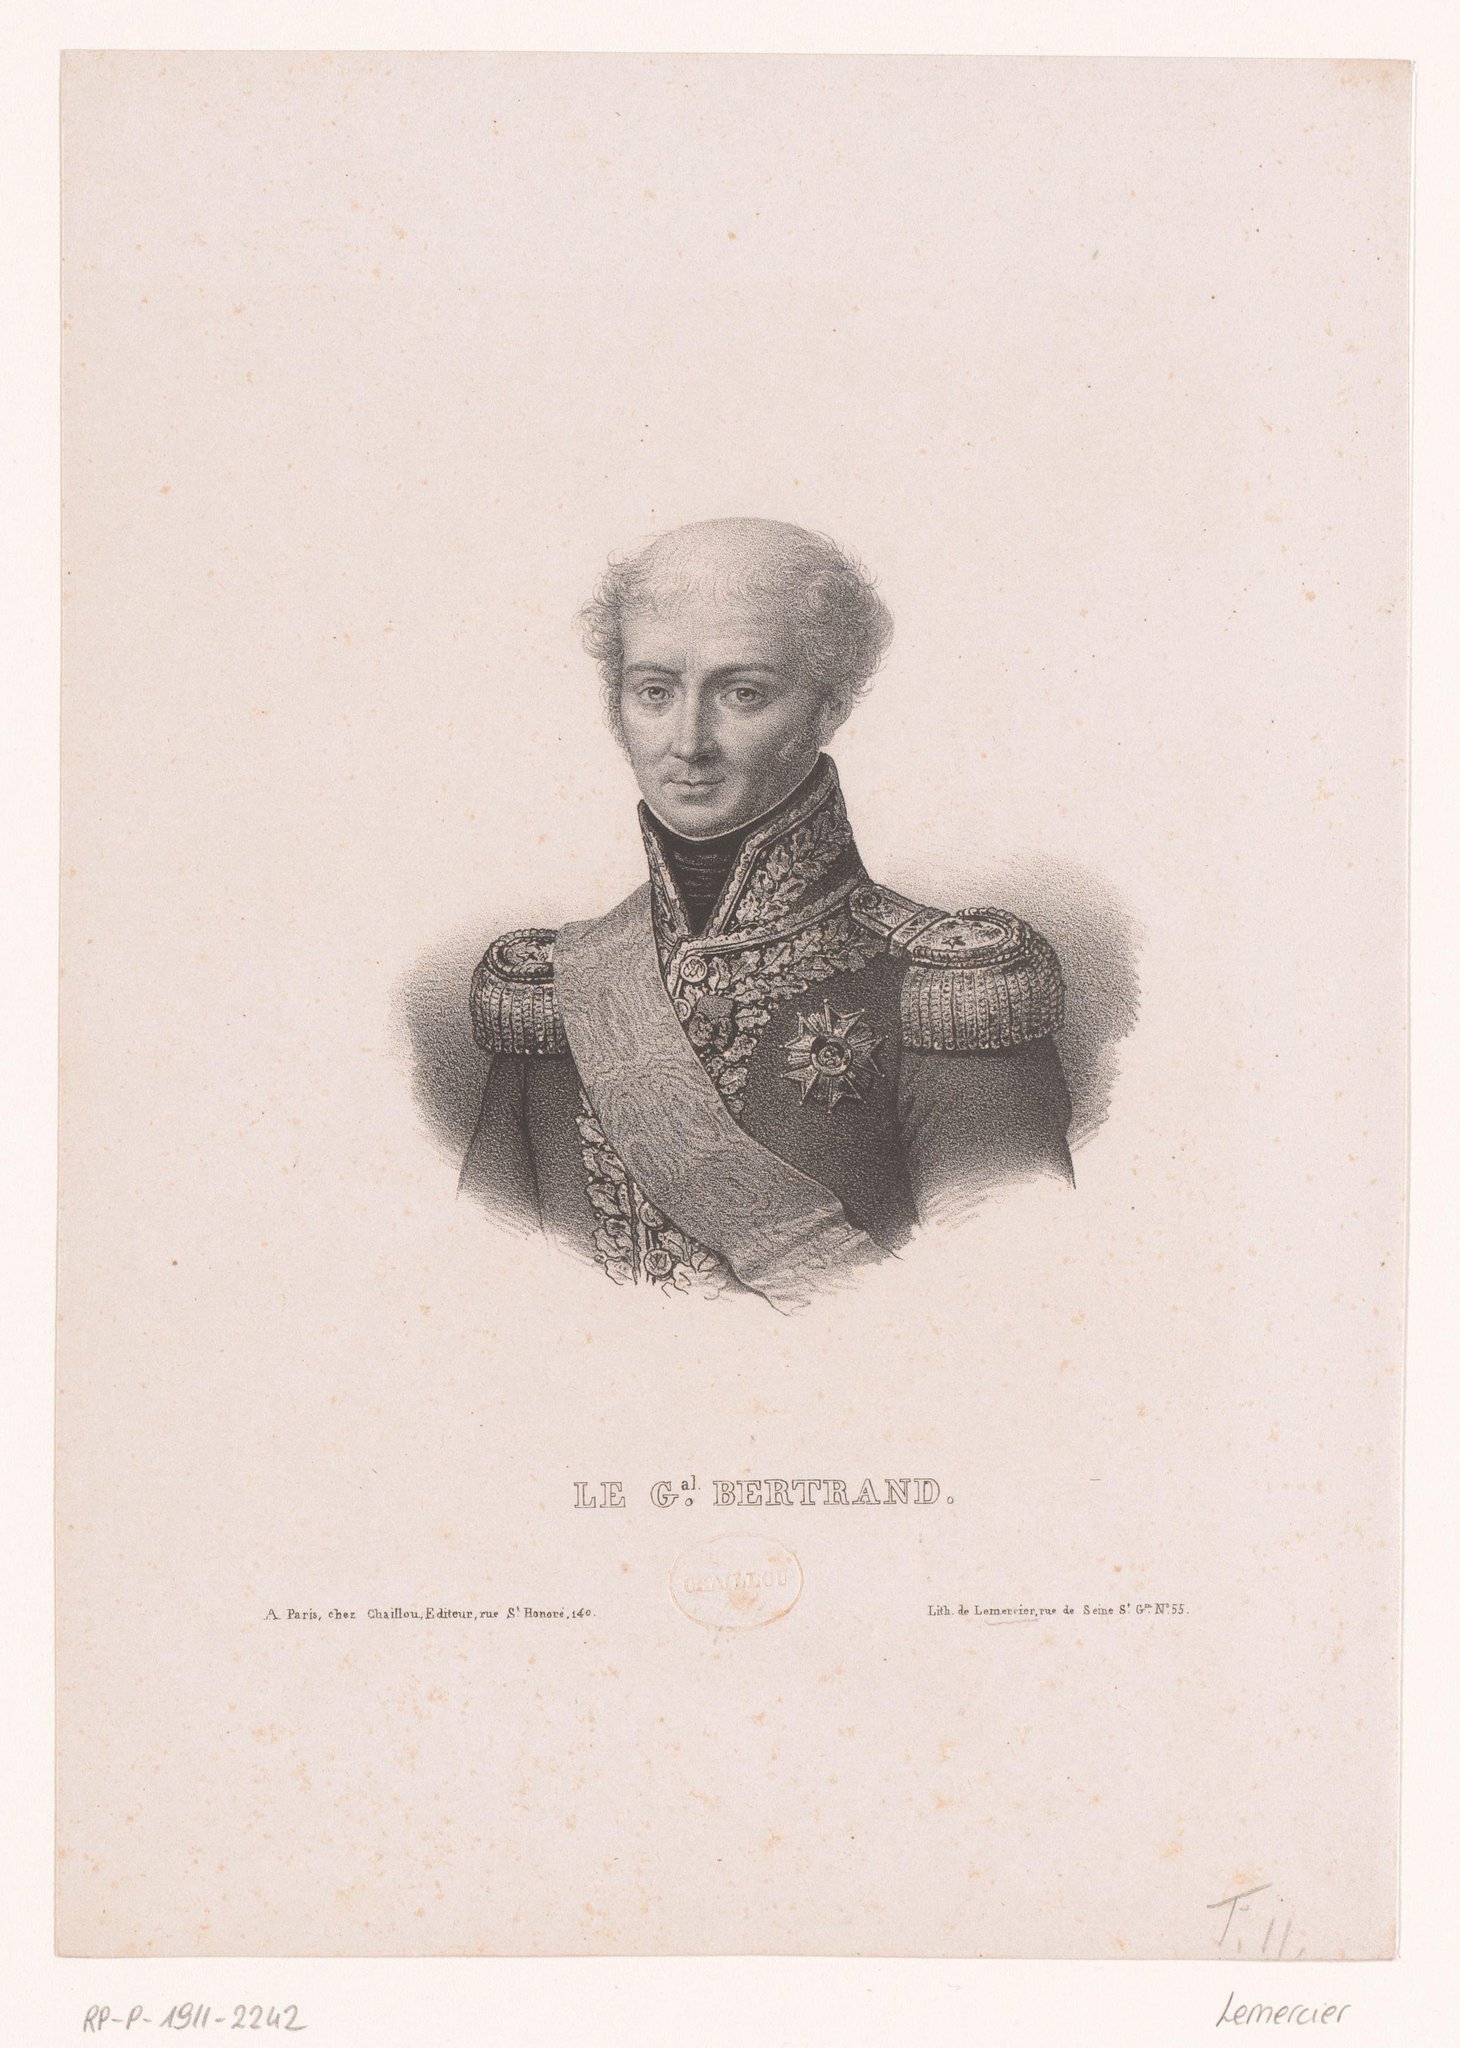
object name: print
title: Le G.al Bertrand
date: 1833-1837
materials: paper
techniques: lithograph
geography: paris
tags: historical persons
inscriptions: check stamp: Lugt 4733, collector's mark: Lugt 2228a